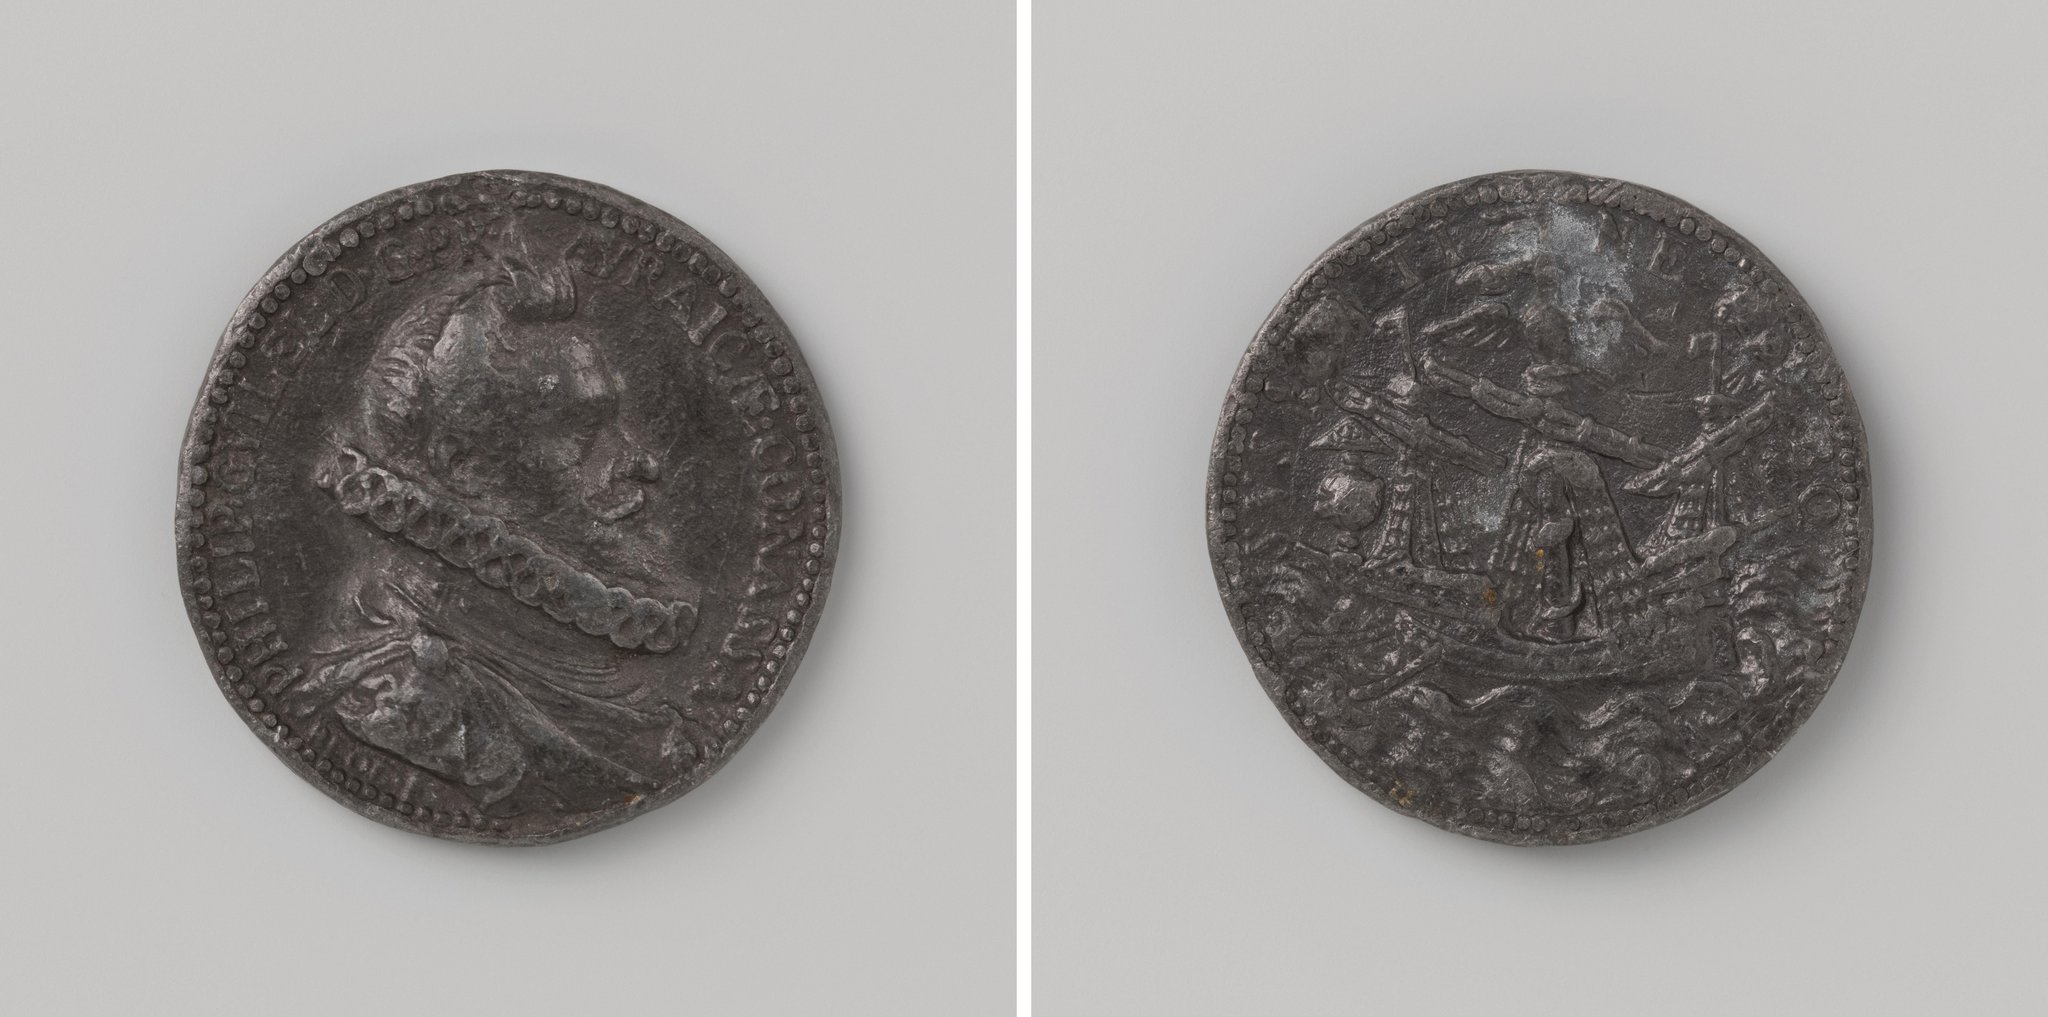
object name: copy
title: Filips Willem, prins van Oranje-Nassau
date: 1579-1596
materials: lead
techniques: casting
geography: flanders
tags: filips willem (prins van oranje)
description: Loden penning. Voorzijde: borststuk man binnen omschrift. Keerzijde: schip bij zware storm, met slang om middelste mast, en adelaar met lauriertak in bek er bovenop zittend, en globe met pyramide erop staande op voetstuk op voorsteven binnen omschrift